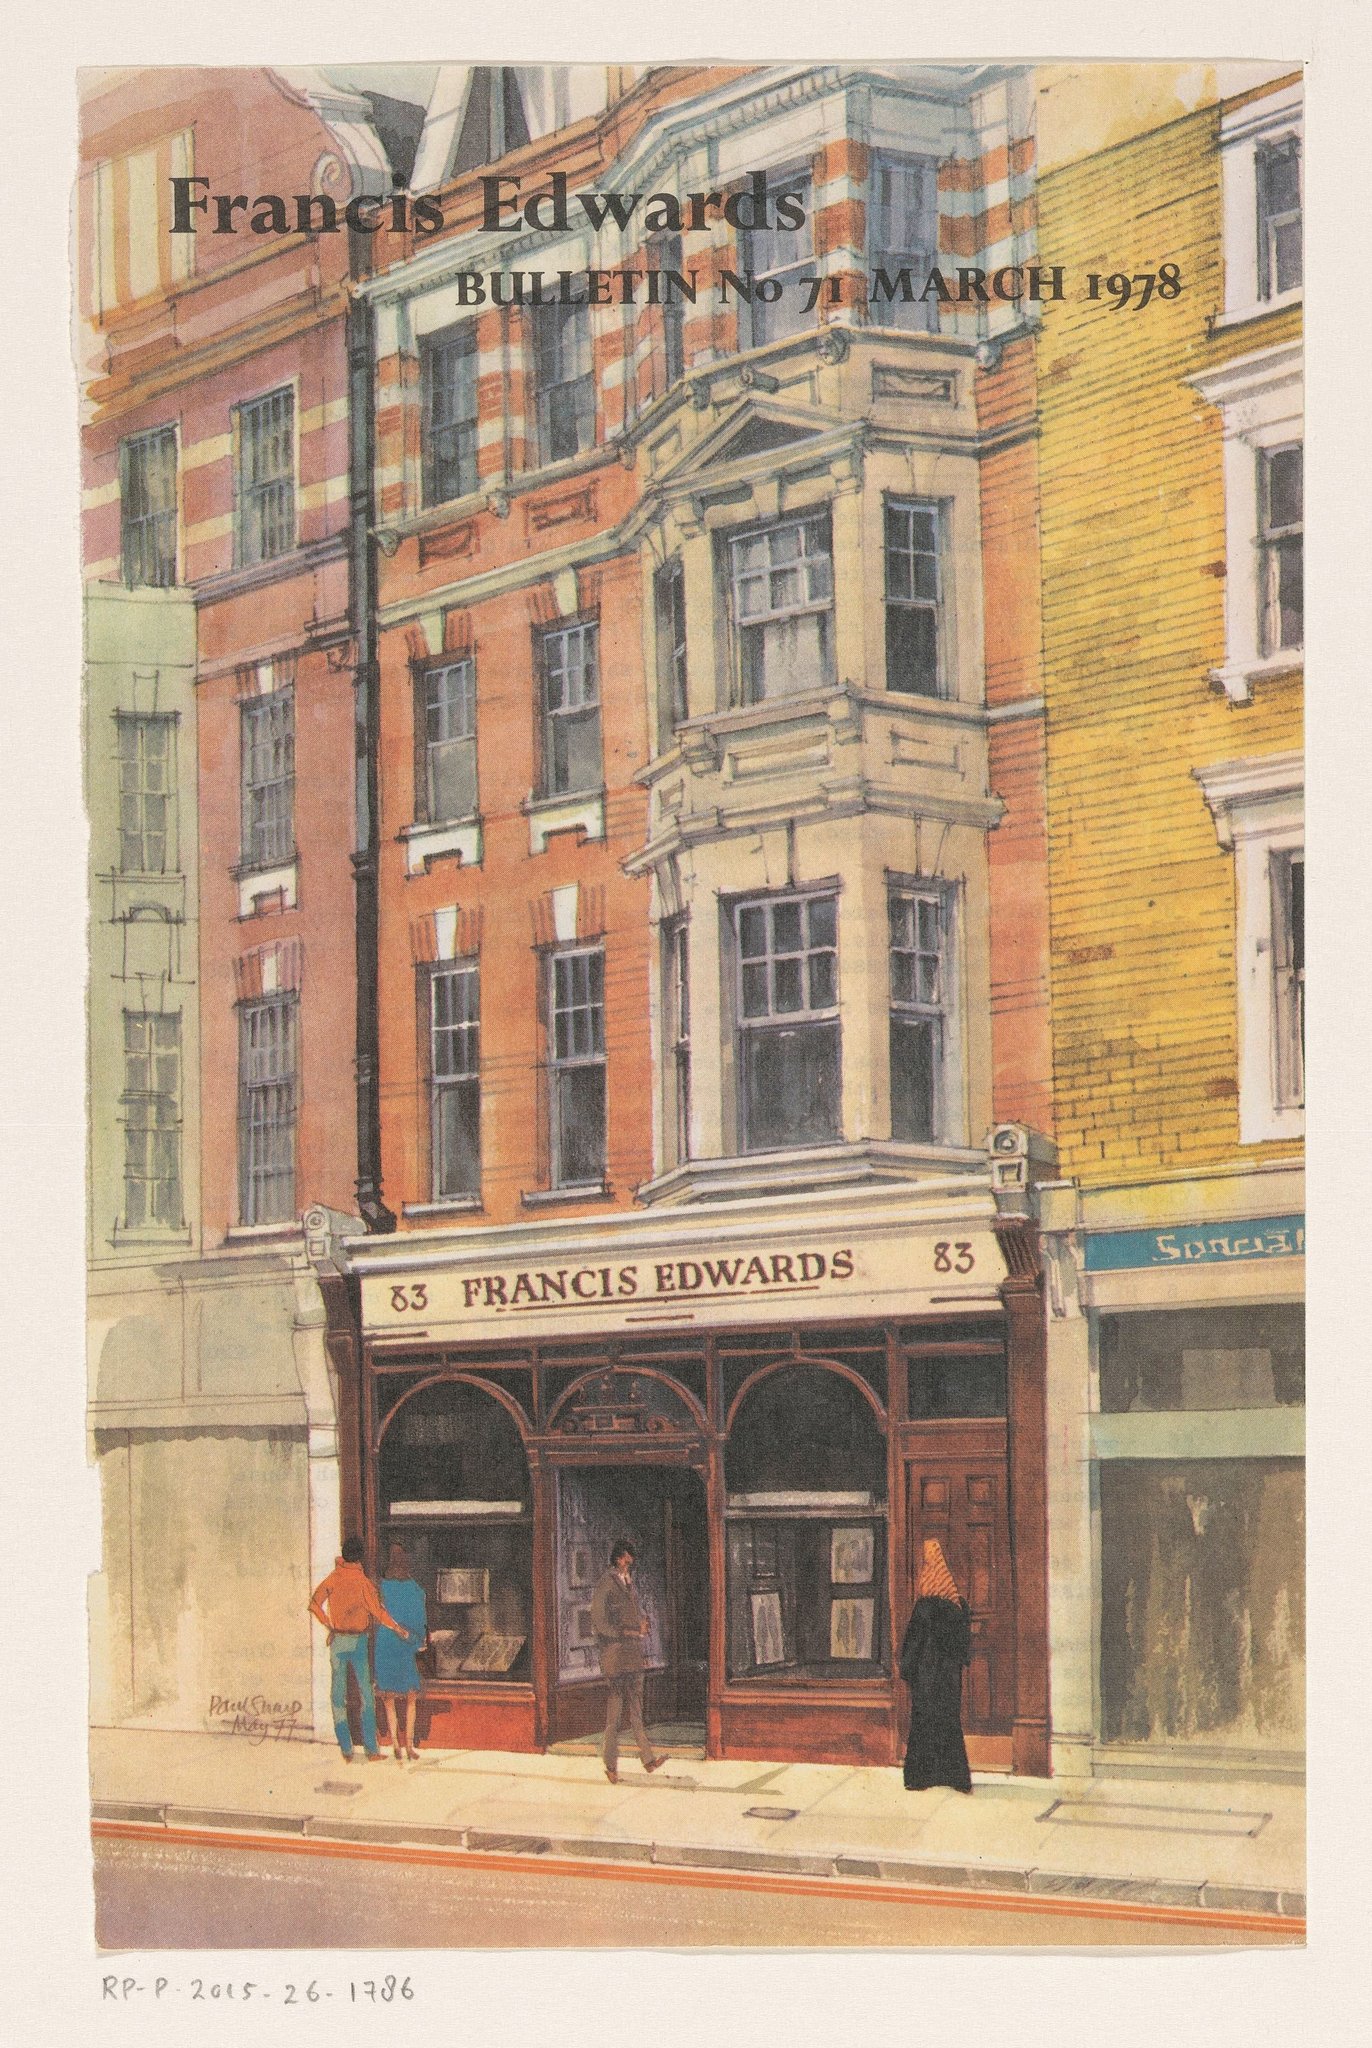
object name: wrapper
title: Etalage van boekhandel Francis Edwards te Londen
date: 1903-1978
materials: paper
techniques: offset printed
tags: shop-window, show-window, book-shop, bookseller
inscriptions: collector's mark: Lugt 2228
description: Prent op de voorzijde van een bulletin. Francis Edwards Rare Books (opgericht in 1855) verhuisde in 1912 naar het pand op 83 Marlybone High Street.